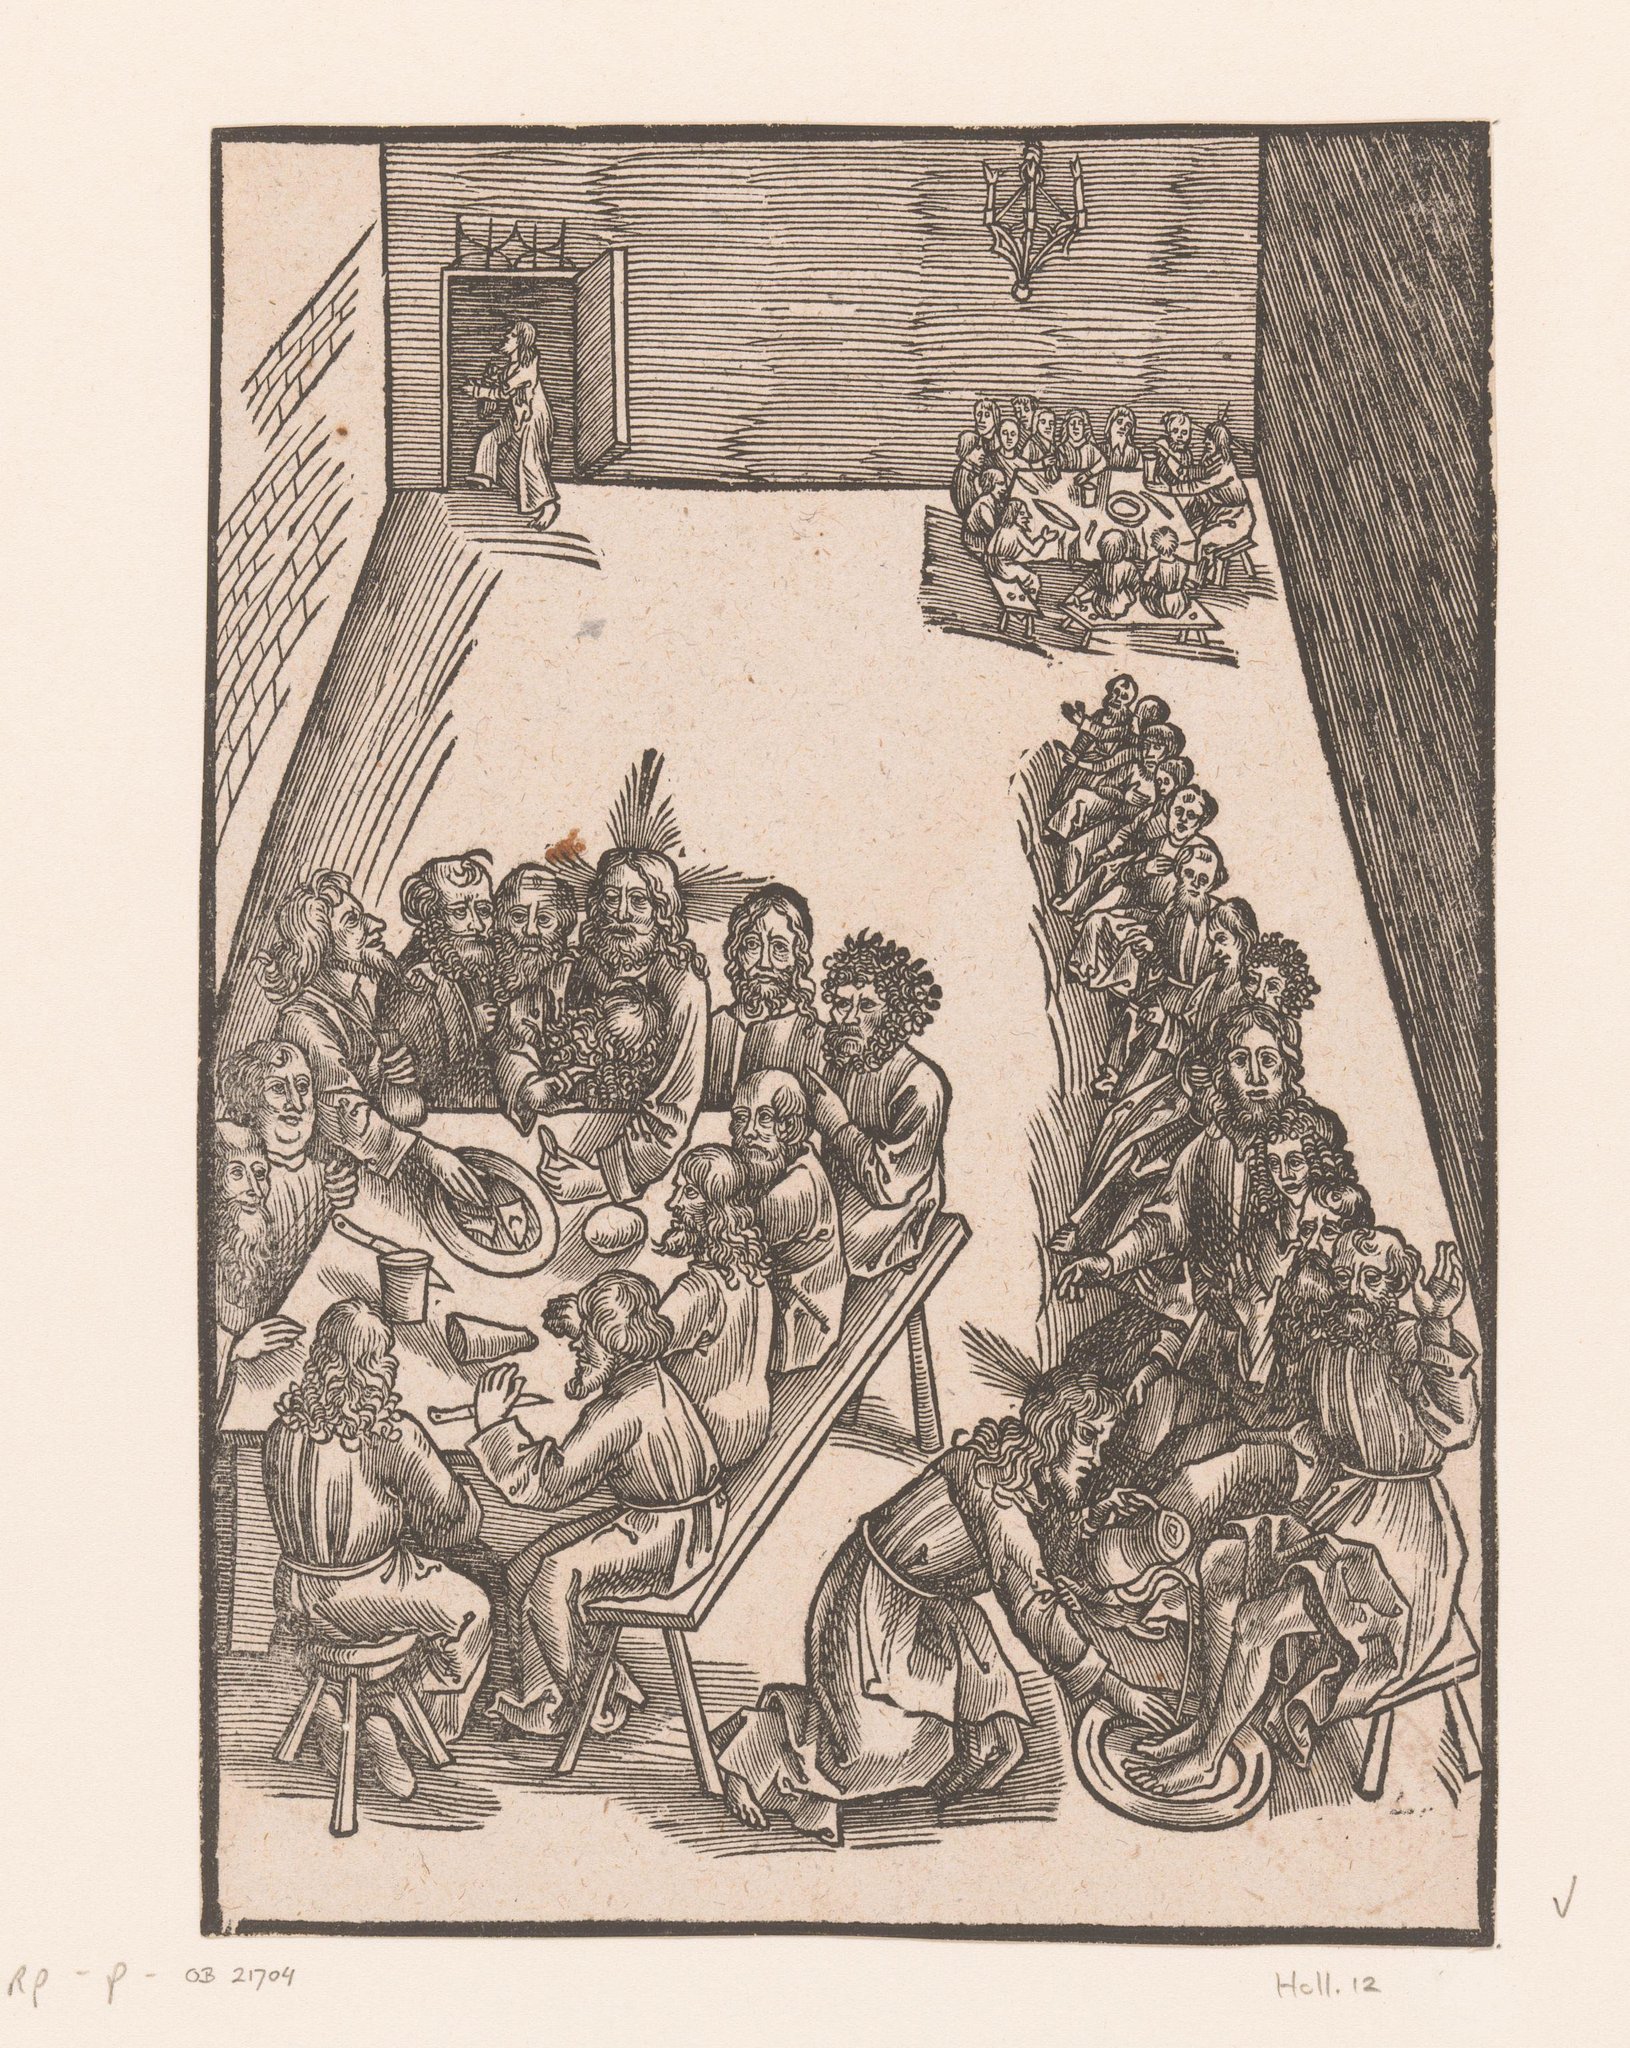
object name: book illustration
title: Passie van Christus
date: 1506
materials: paper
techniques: woodcut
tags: christ washes the feet of the apostles (john 13:1-20), last supper (in general) (matthew 26:21-35; mark 14:18-31; luke 22:3, 22:15-23; john 13:21-38)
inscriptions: collector's mark: Lugt 240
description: Afkomstig uit: Der Text des Passions oder Lidens Christi (...). Straatsburg: N. Ringmann, 1506.